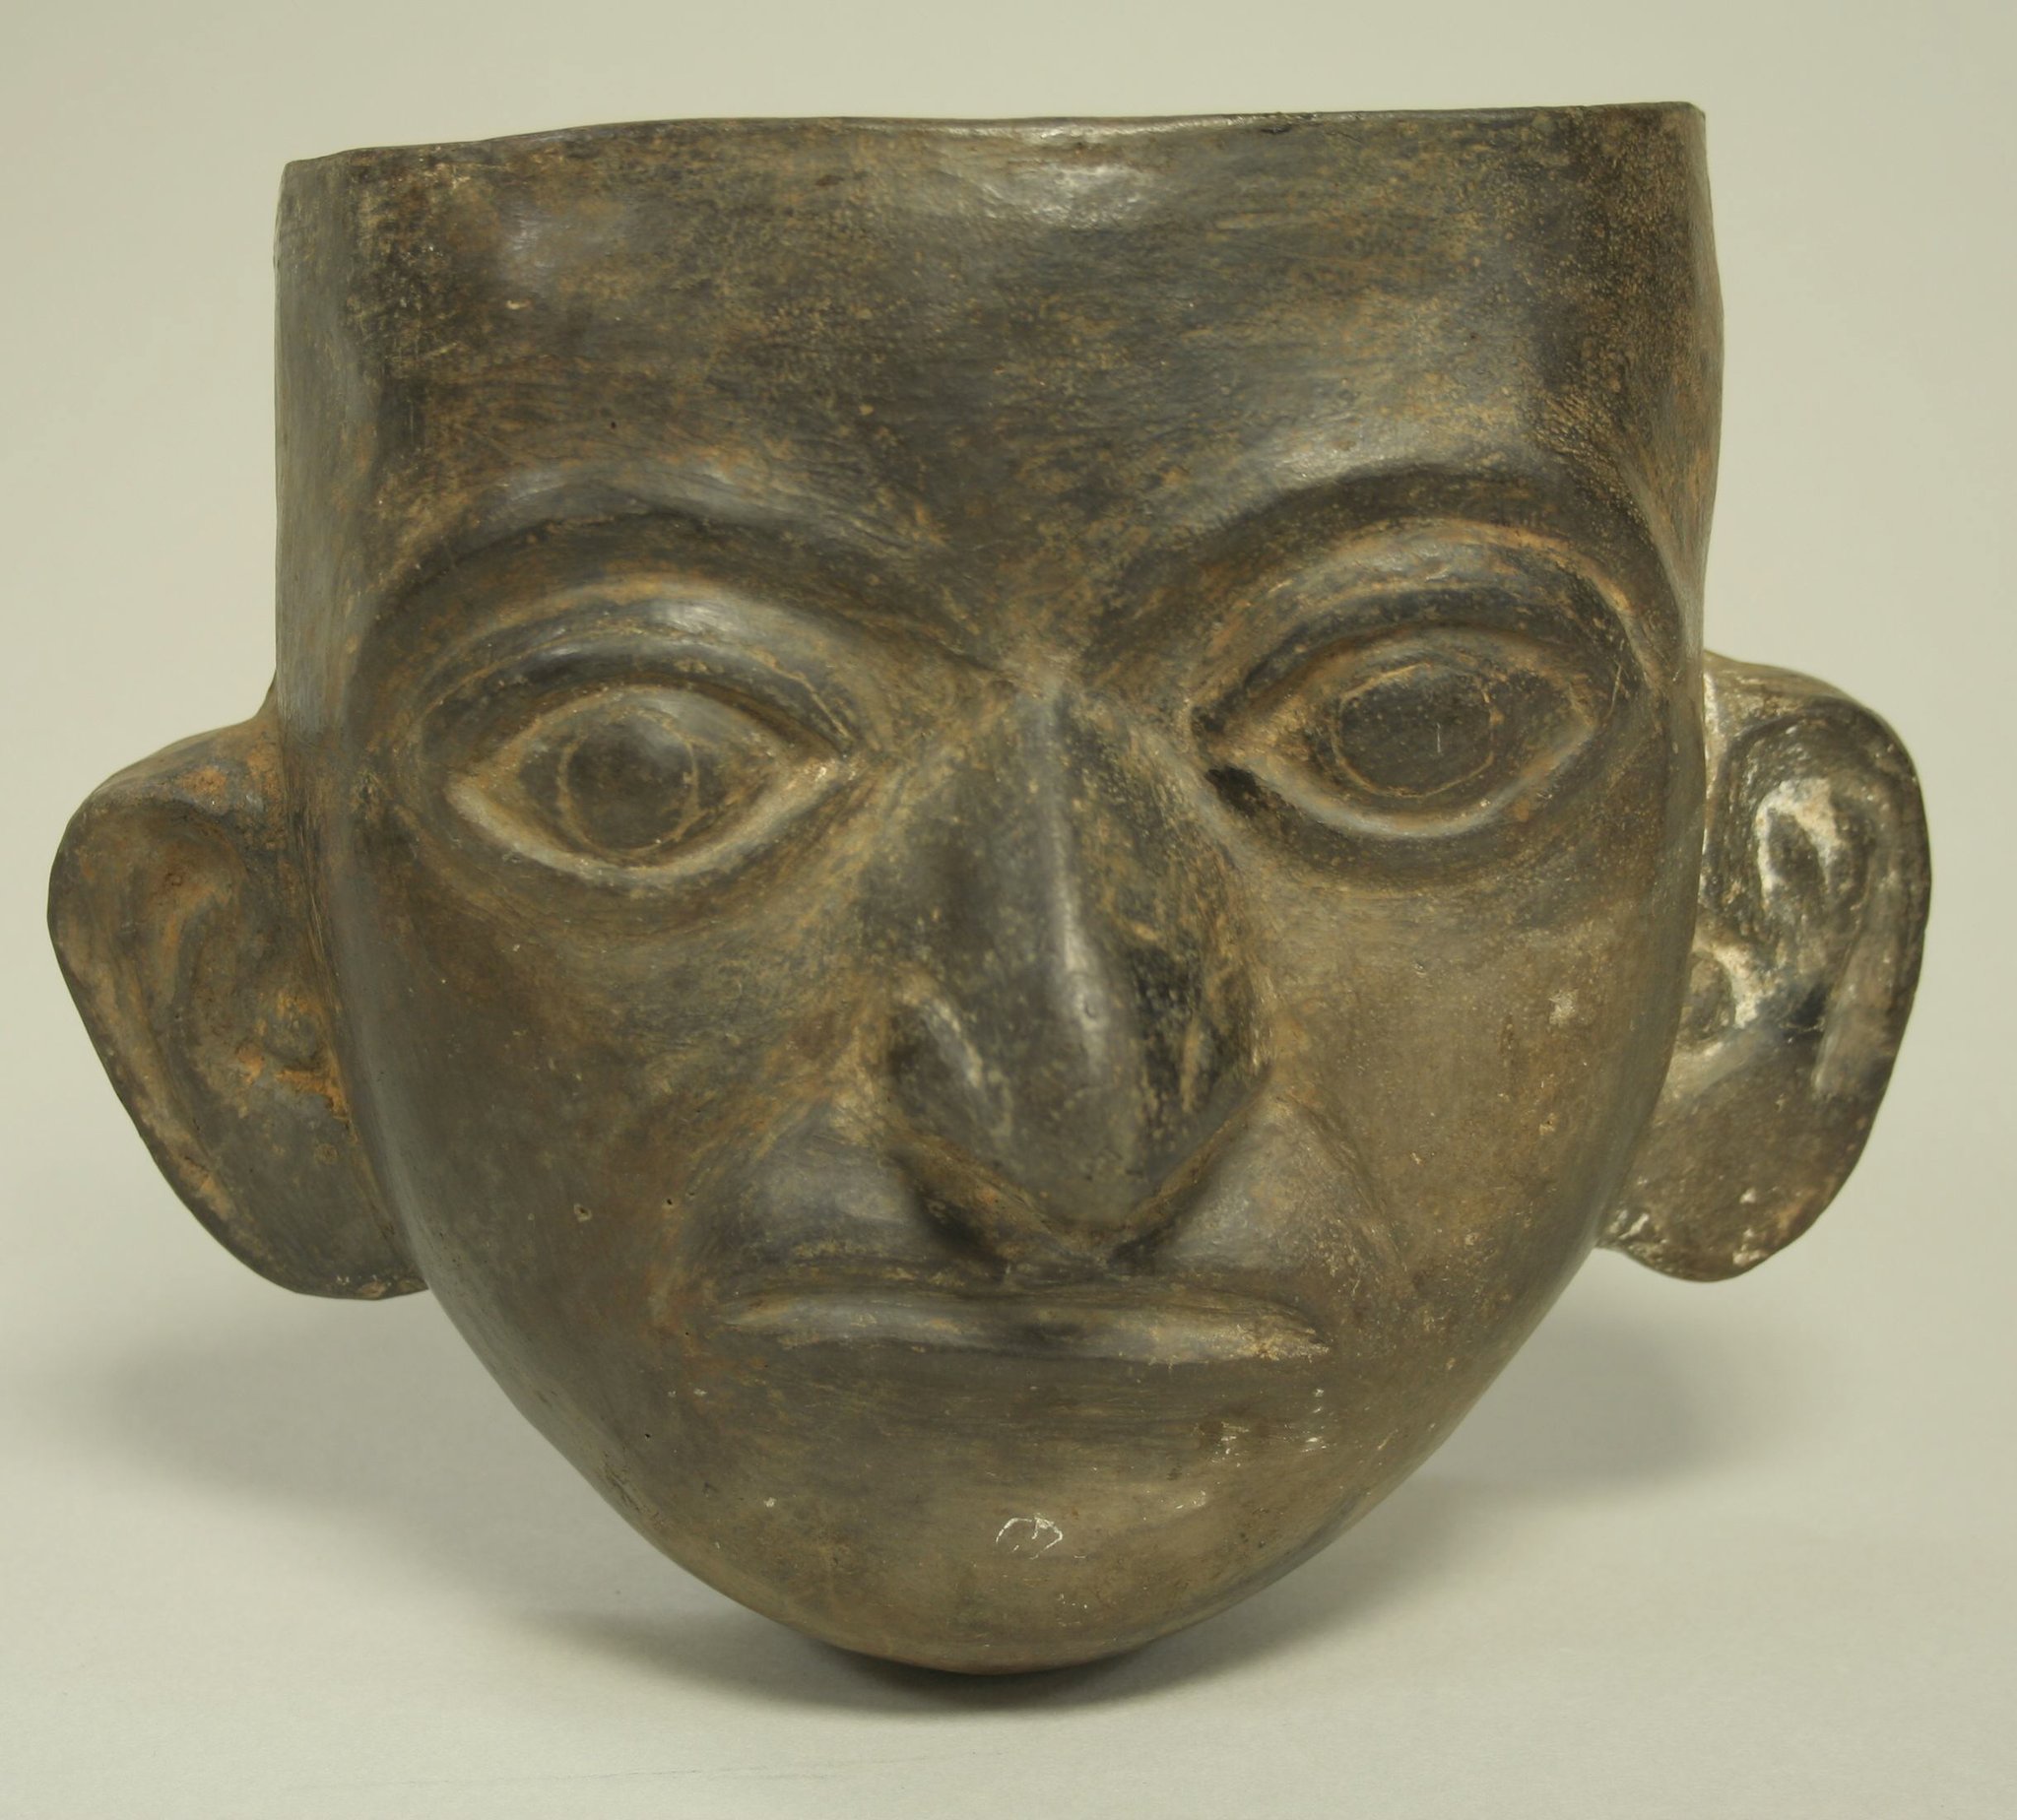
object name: mask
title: Ceramic Face Mask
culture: moche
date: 101-700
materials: ceramic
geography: peru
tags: faces